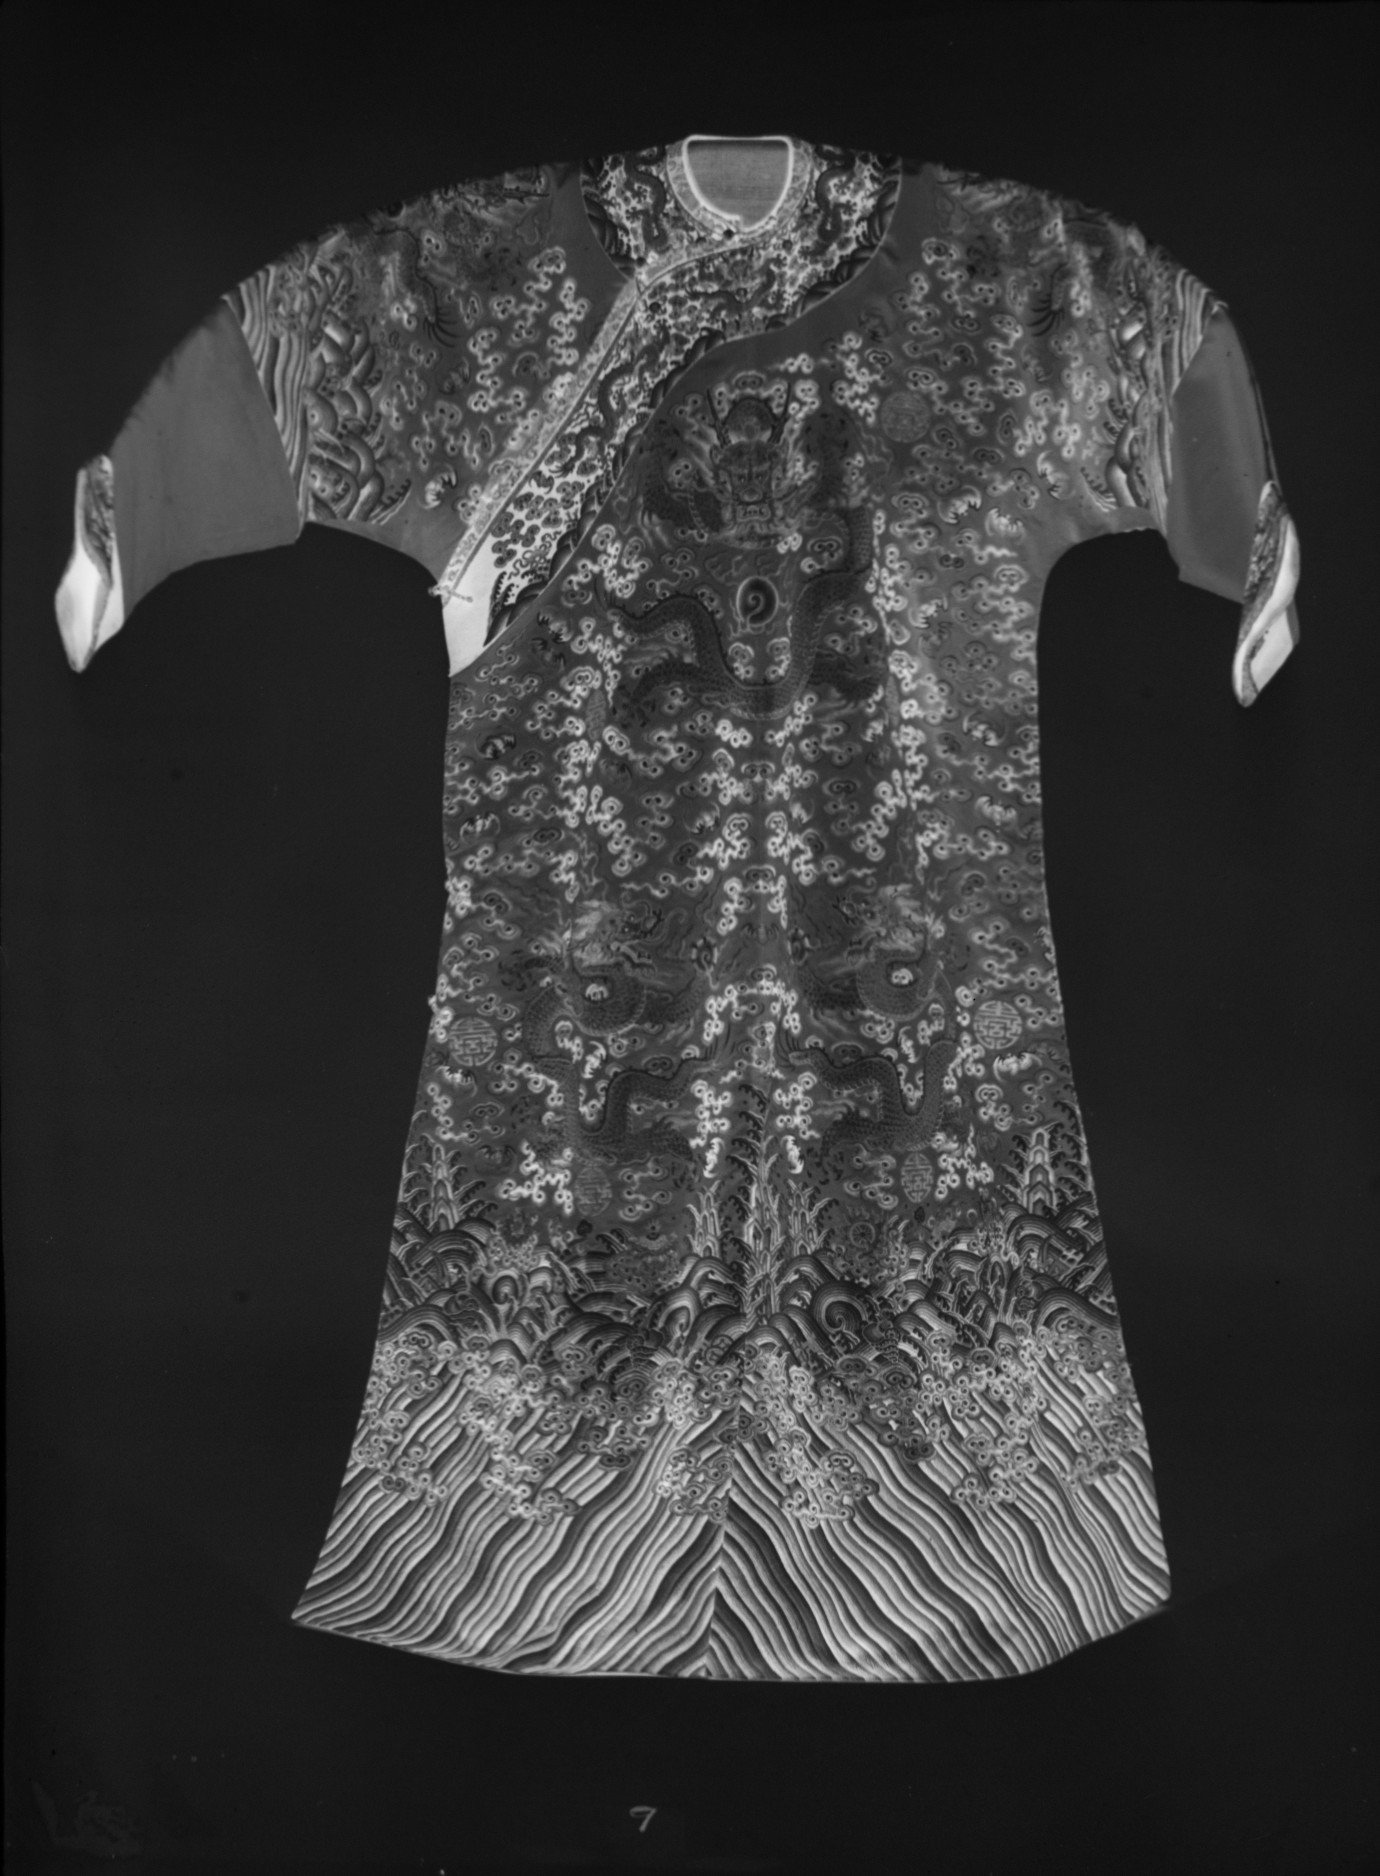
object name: robe, imperial court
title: Imperial Court Robe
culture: chinese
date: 1796-1820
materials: metal thread, silk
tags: dragons